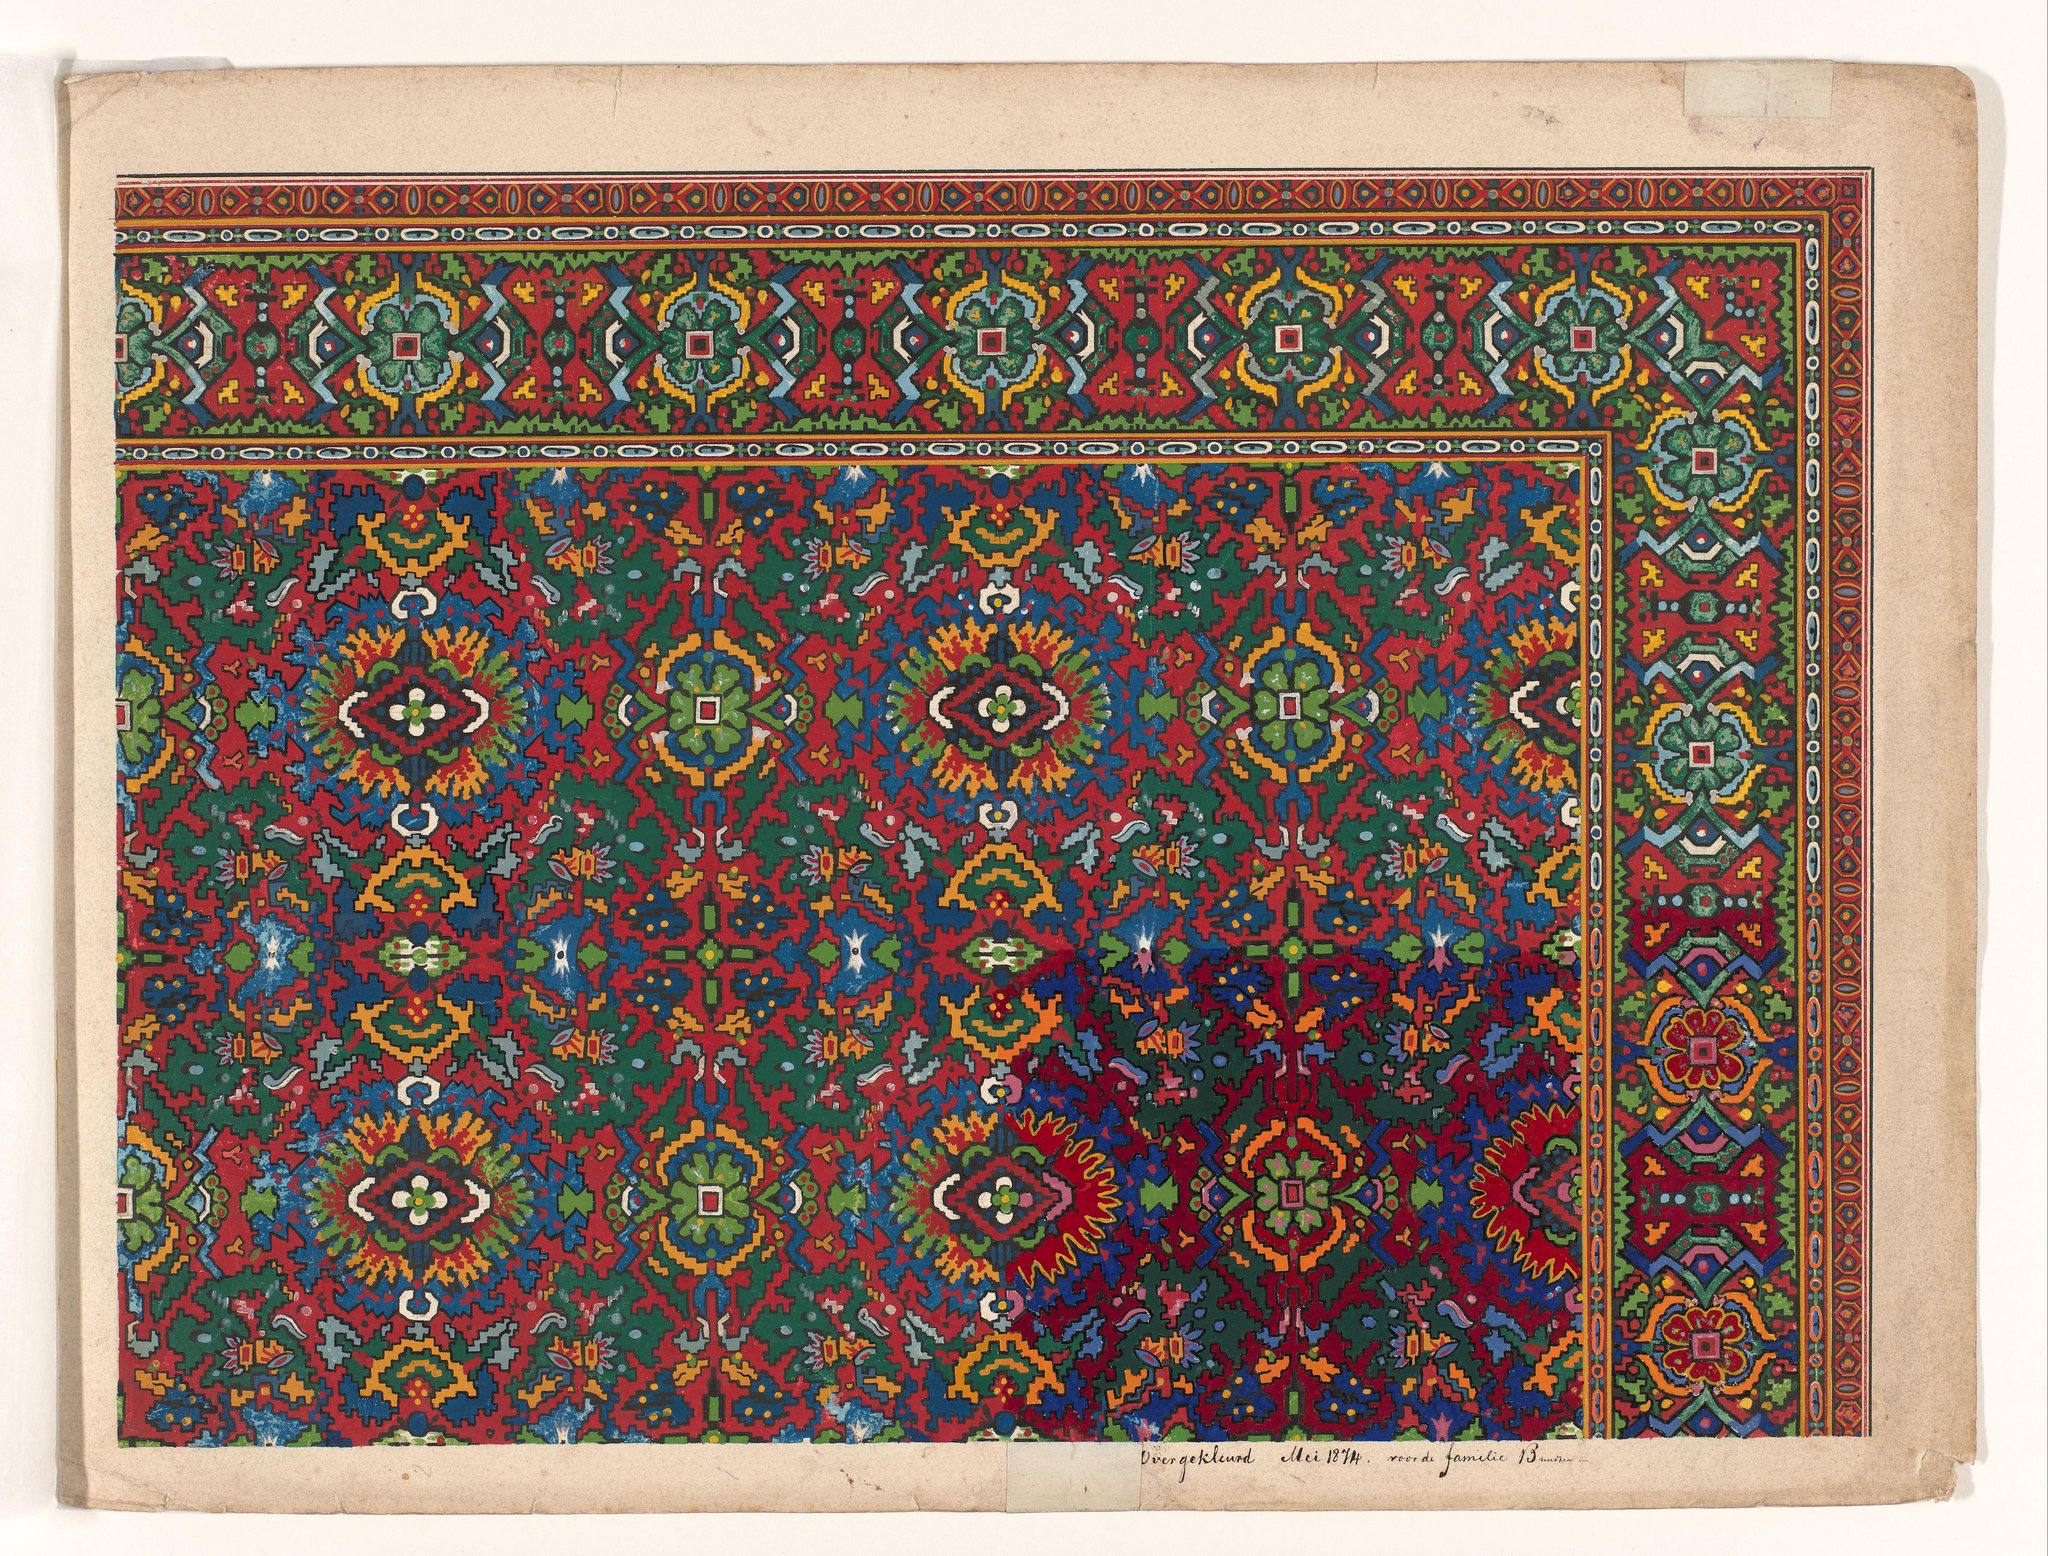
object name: drawing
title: Ontwerp voor een tapijt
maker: Anonymous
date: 1874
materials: gouache, paper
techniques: brush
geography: deventer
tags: ornaments ~ art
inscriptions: annotation: ‘Overgekleurd Mei 1874 voor de familie Bu[...]ea’, inscription: ‘L’, retailer's mark: ‘JHS.’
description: De presentatietekeningen BK-1971-77-1 t/m 86 zijn kopieën van de originele ontwerptekeningen. Ze werden gemaakt voor vertegenwoordigers van bijvoorbeeld magazijnen, die ze aan hun klanten konden tonen. De meeste tekeningen tonen een kwart van het dessin inclusief rand, middenpartij (de zogenaamde grond of fond) en centraal medaillon. Door het gebruik van spiegels kan de illusie van het gehele tapijt worden opgeroepen. Een deel van de tekeningen heeft een alfabetische opeenvolgende letter als kenmerk, de andere groep een cijfer.Waarschijnlijk is de reeks dessins met een letter eerder samengesteld dan de genummerde tekeningen.